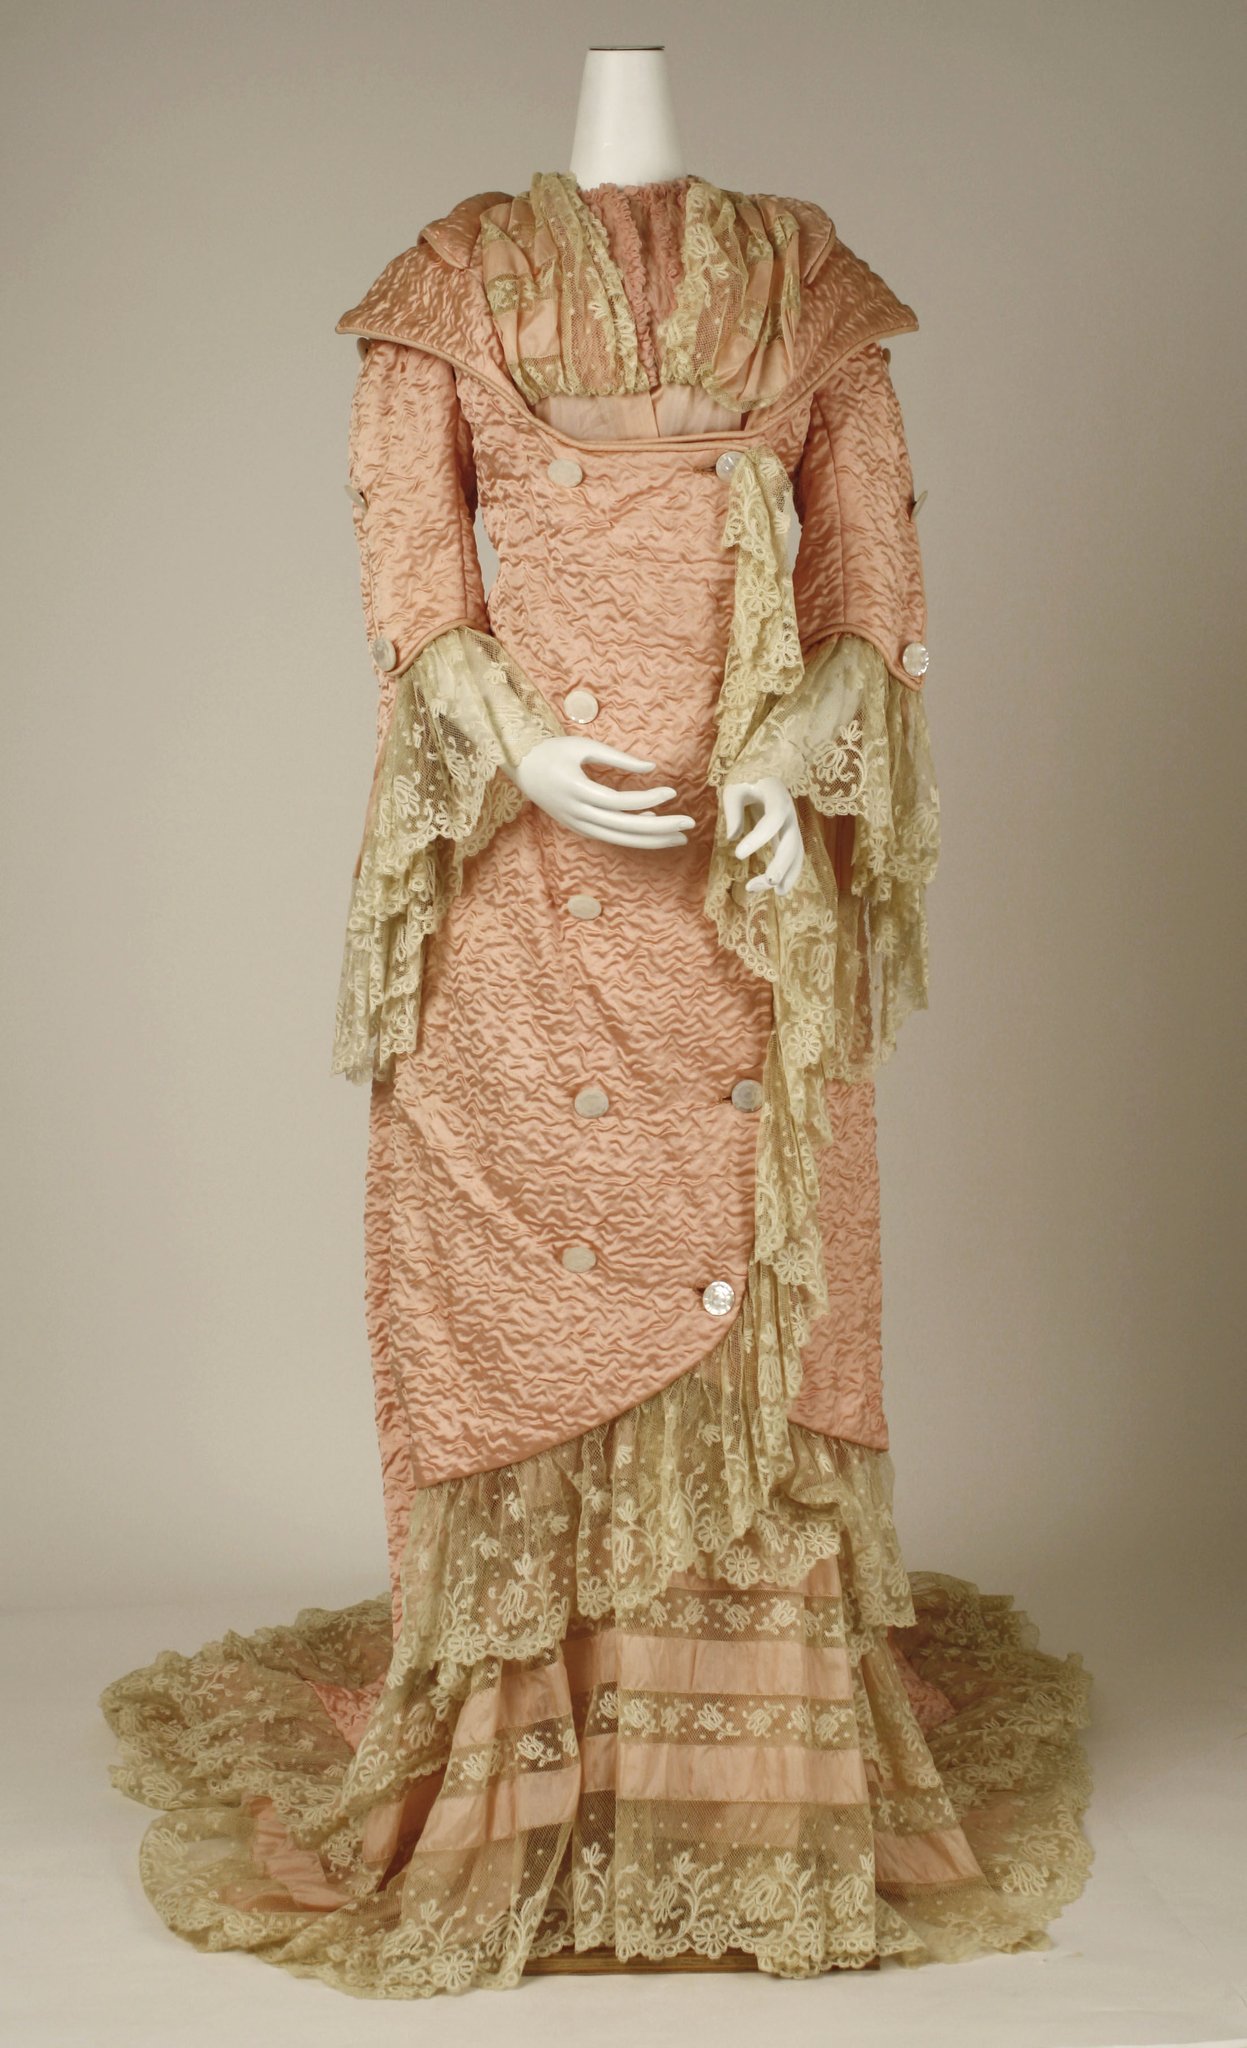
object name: negligée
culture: french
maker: félix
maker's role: design house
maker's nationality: french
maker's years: 1846-1901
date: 1880-1889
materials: silk